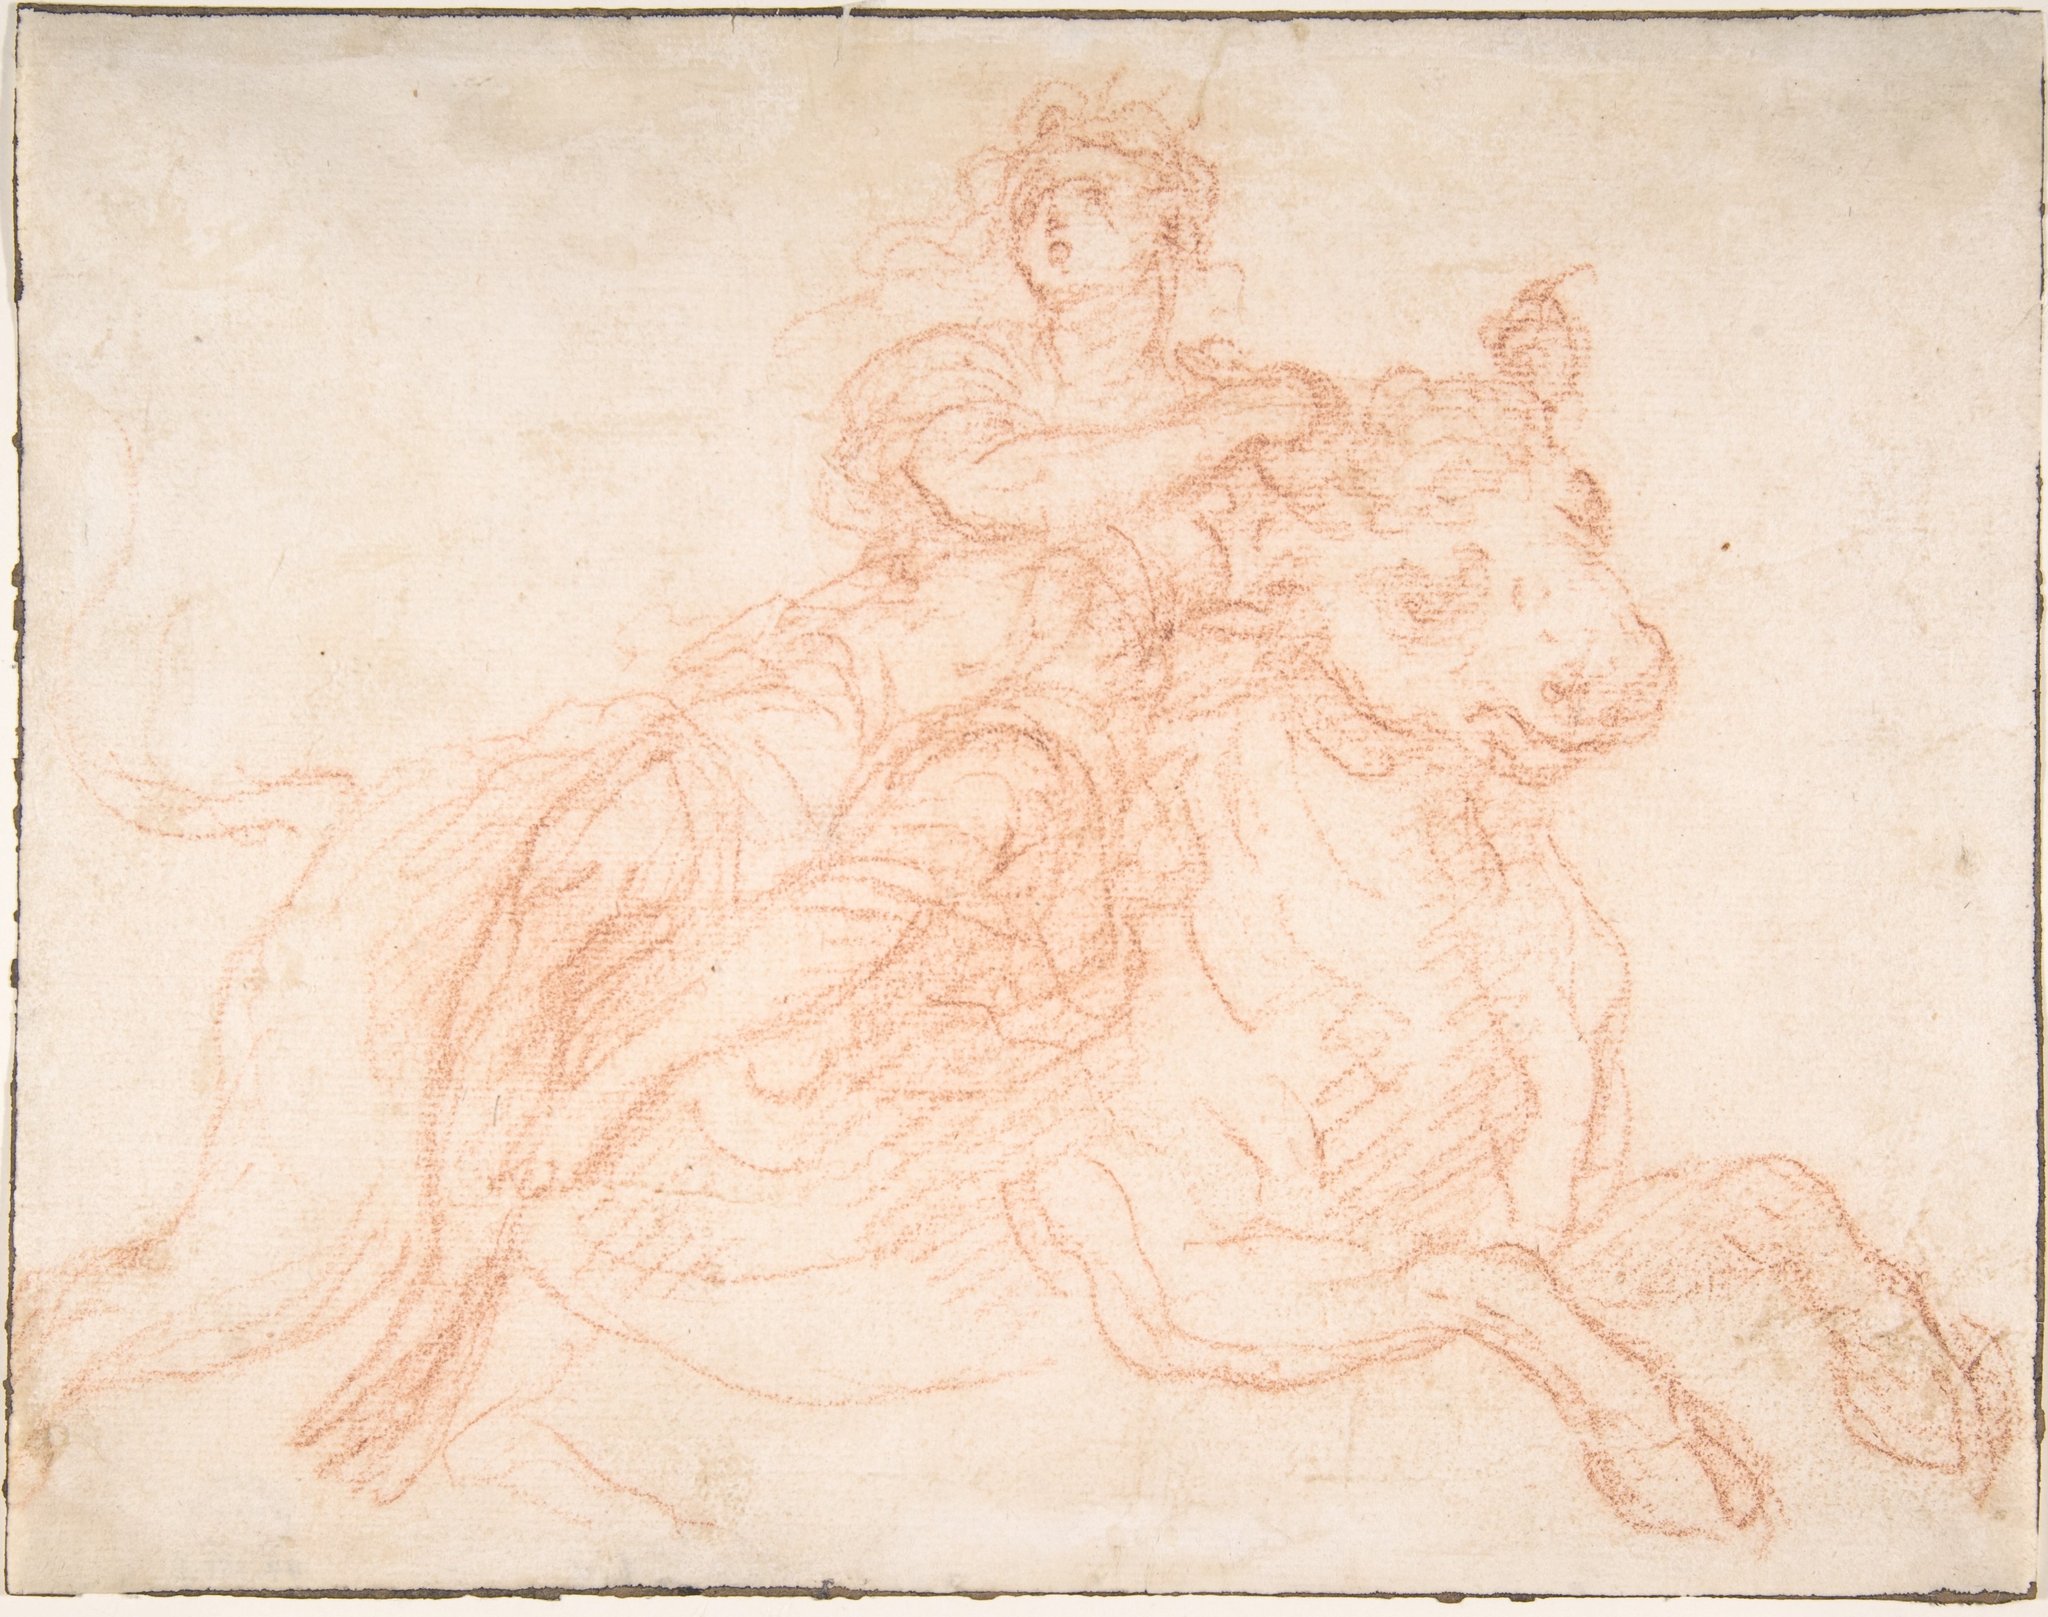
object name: drawing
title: Europa and the Bull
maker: anonymous, italian, bolognese, 17th century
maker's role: artist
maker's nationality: italian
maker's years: 1600-1700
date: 1601-1700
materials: chalk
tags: europa,bulls